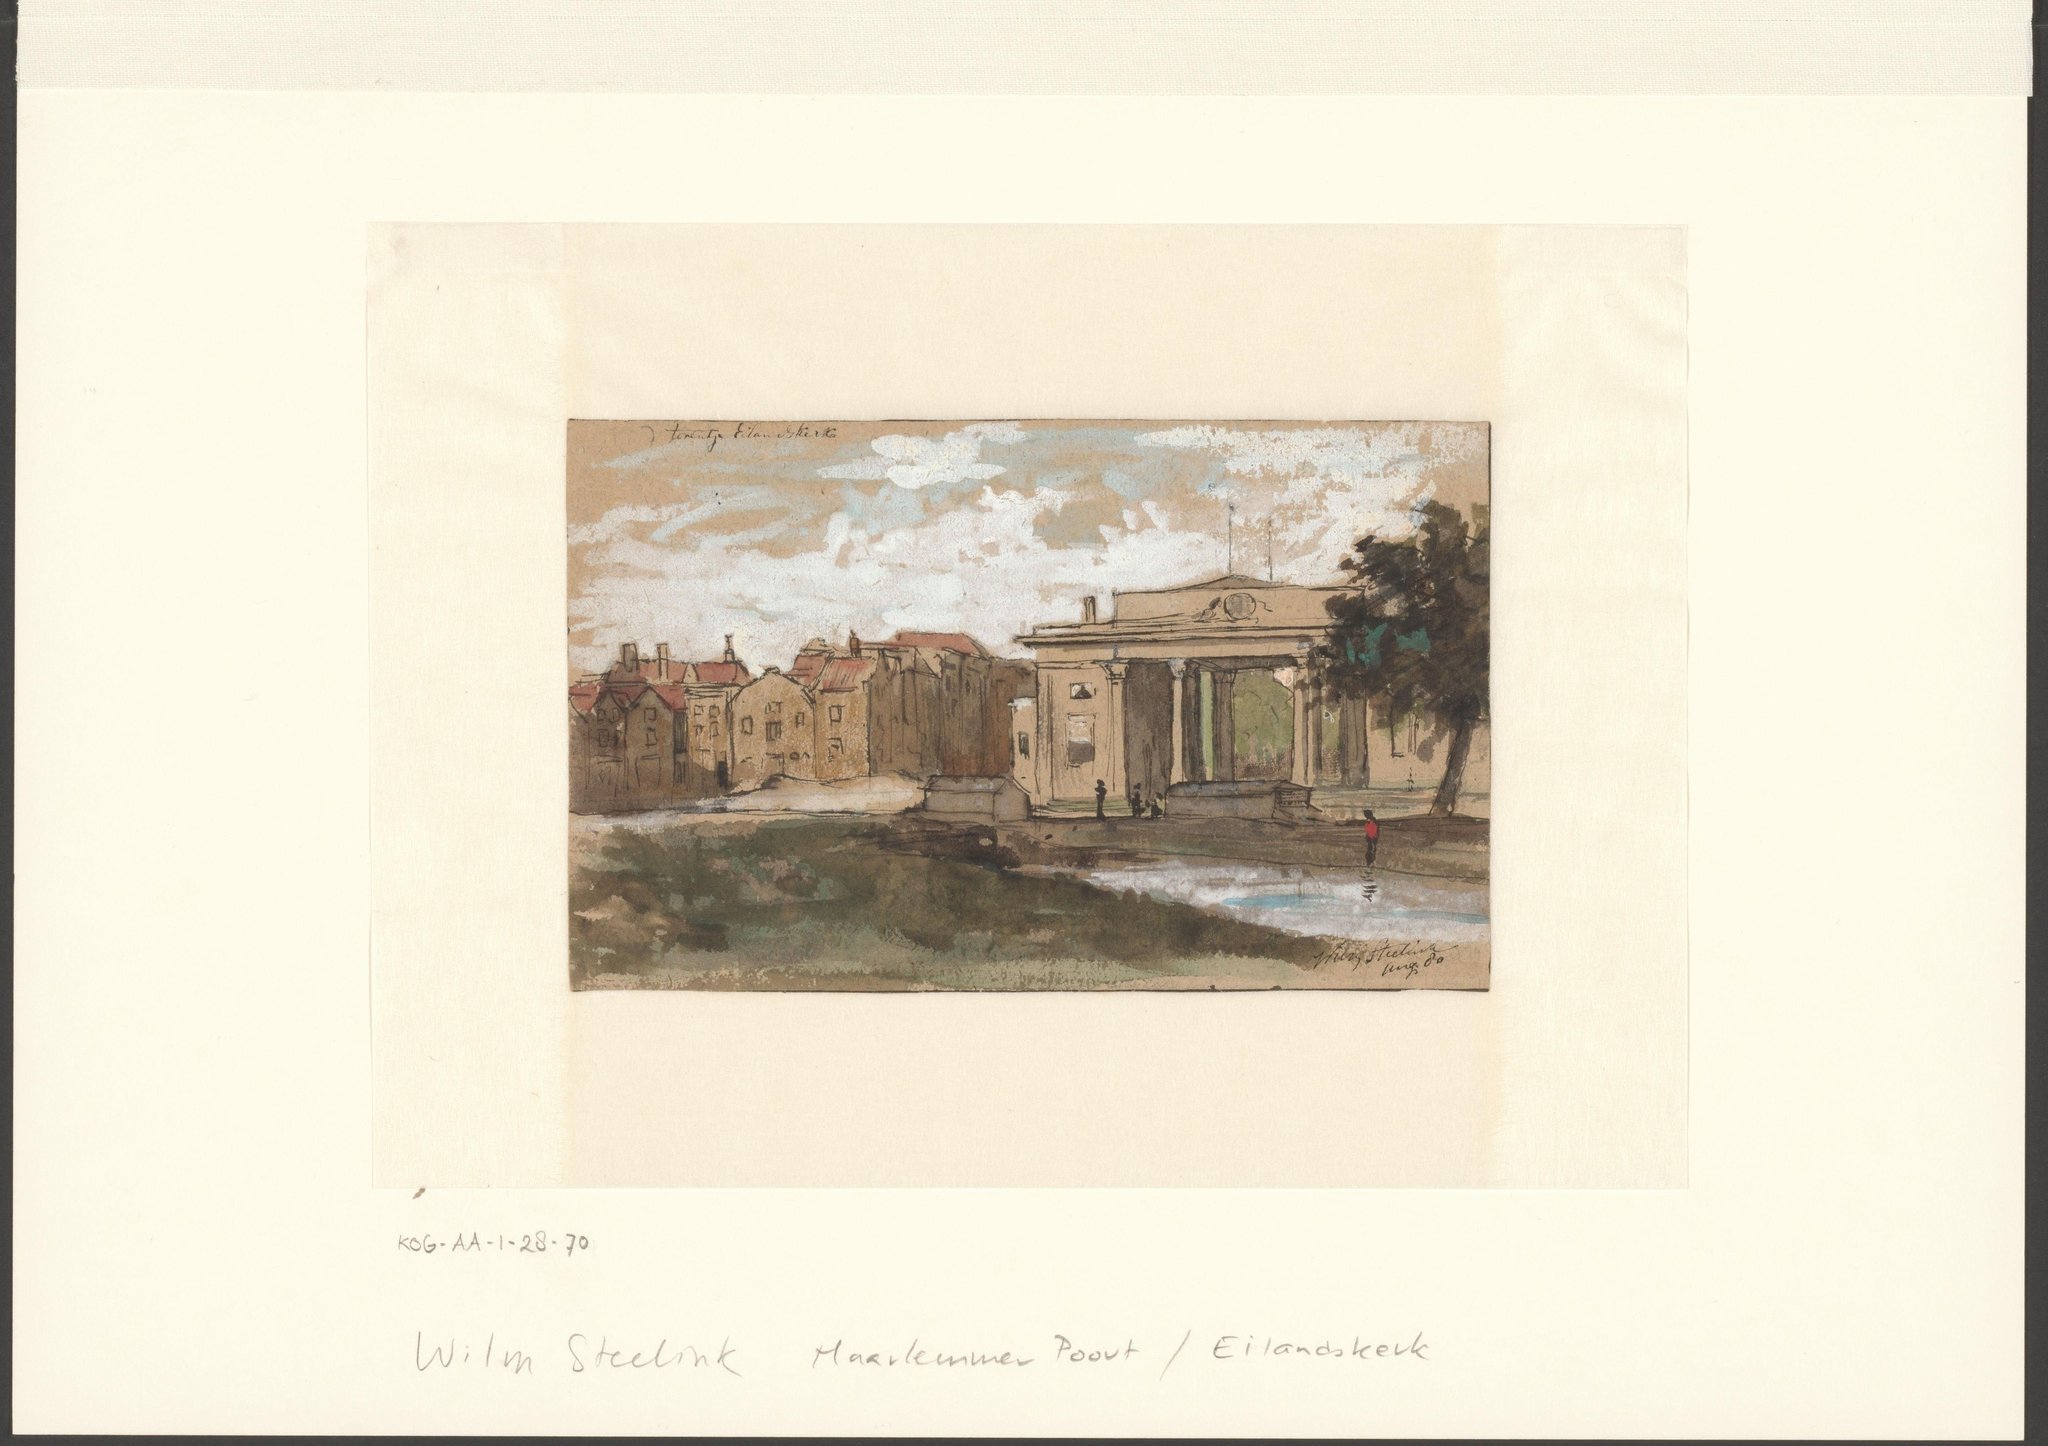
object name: drawing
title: Gezicht op de Willemspoort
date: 1808-1880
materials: paint, gouache, ink, paper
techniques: brush, pen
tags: city-view in general; 'veduta', city-gate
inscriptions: signature, date and inscription: ‘torentje Eilandskerk / Wilm Steelink / Aug. 80’, inscription: ‘28.70’, inscription: ‘De Willemspoort gezien (...) het voormalige station’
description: Onderwerpsrubriek binnen de Atlas Amsterdam: Willemspoort.